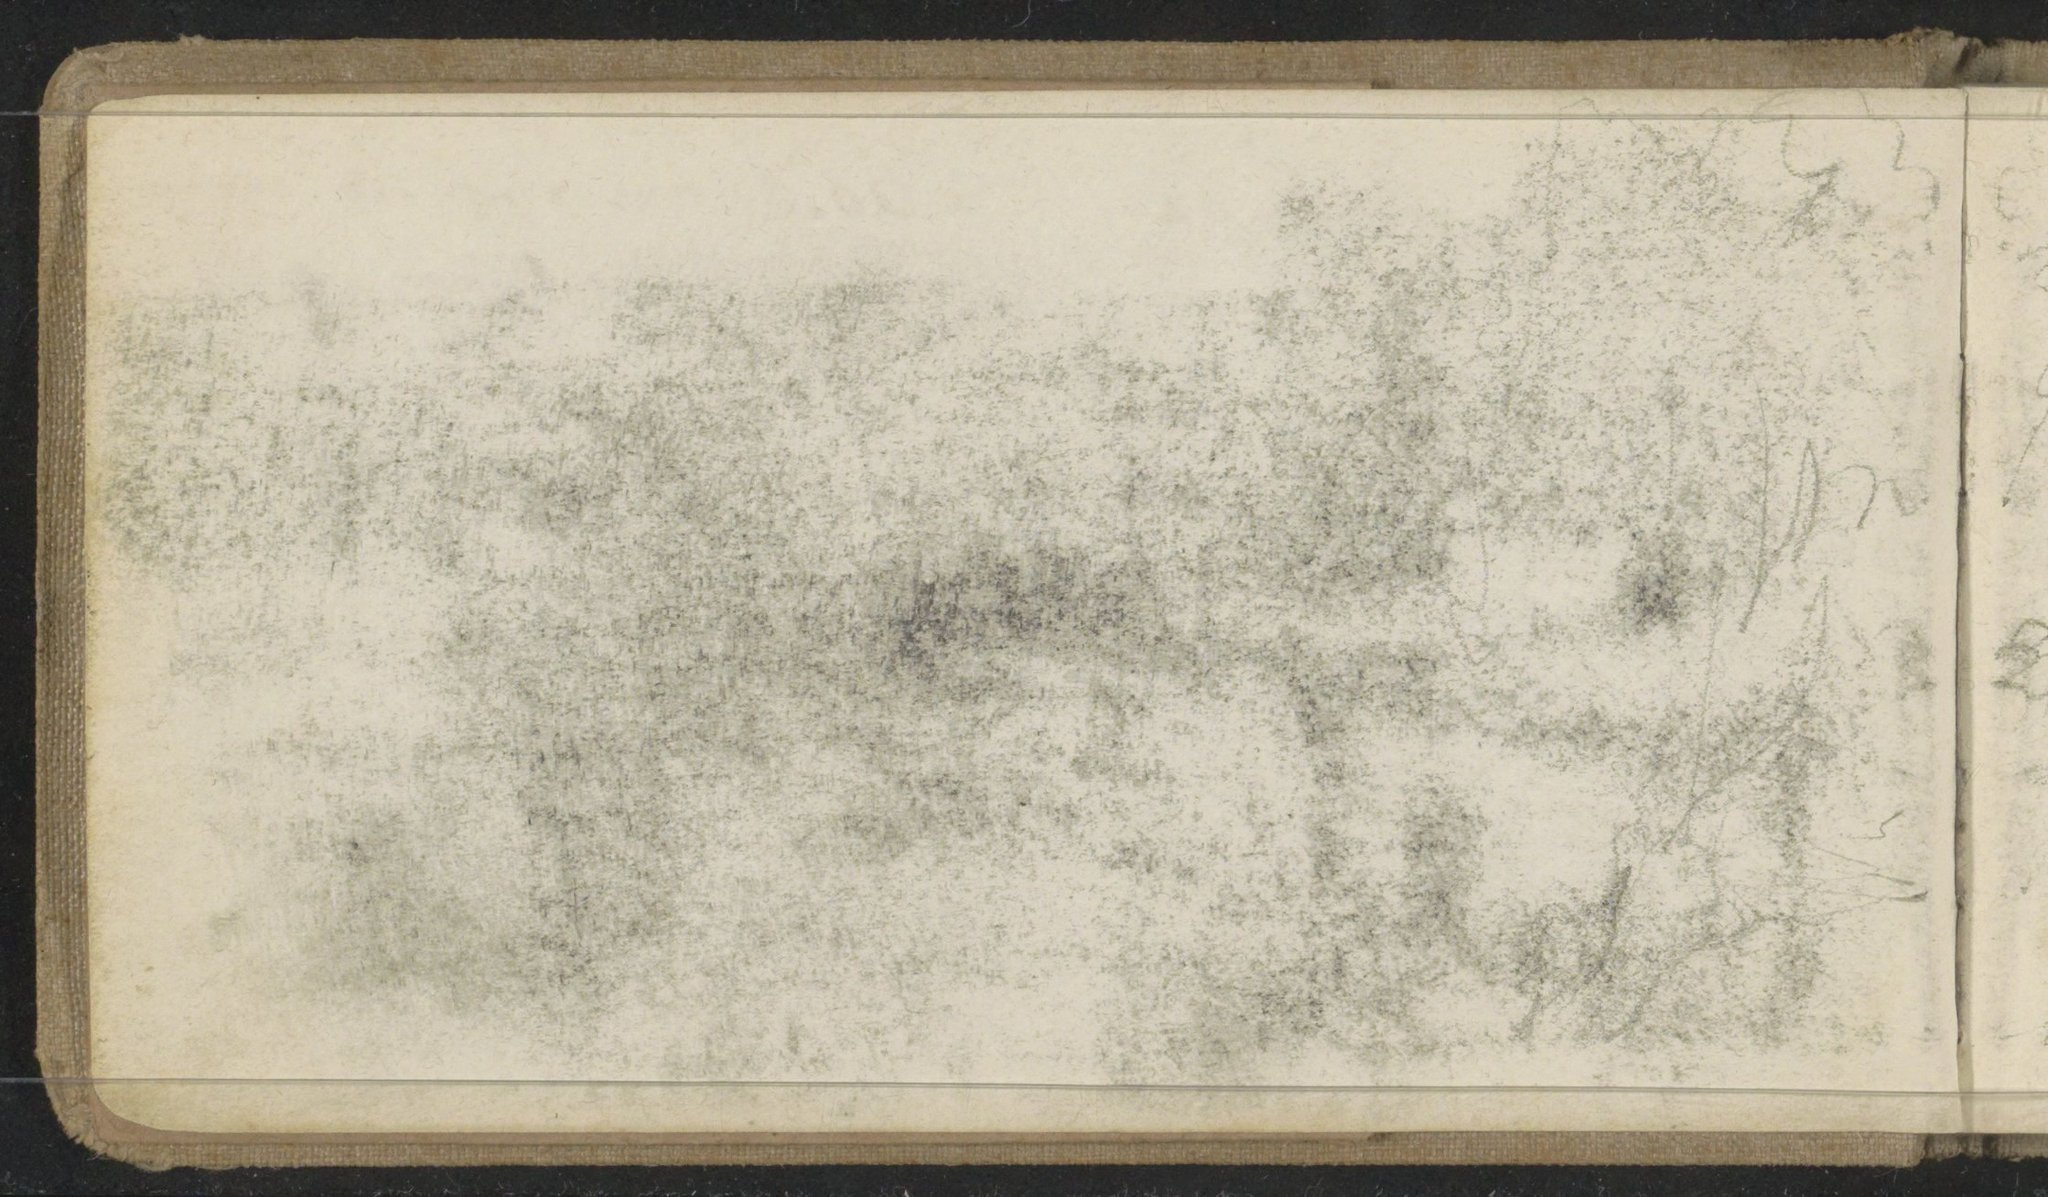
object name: sketchbook leaf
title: Studies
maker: willem cornelis rip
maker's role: draughtsman, painter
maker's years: 1856-1922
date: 1895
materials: paper, pencil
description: Blad 1 verso uit een schetsboek met 39 bladen.